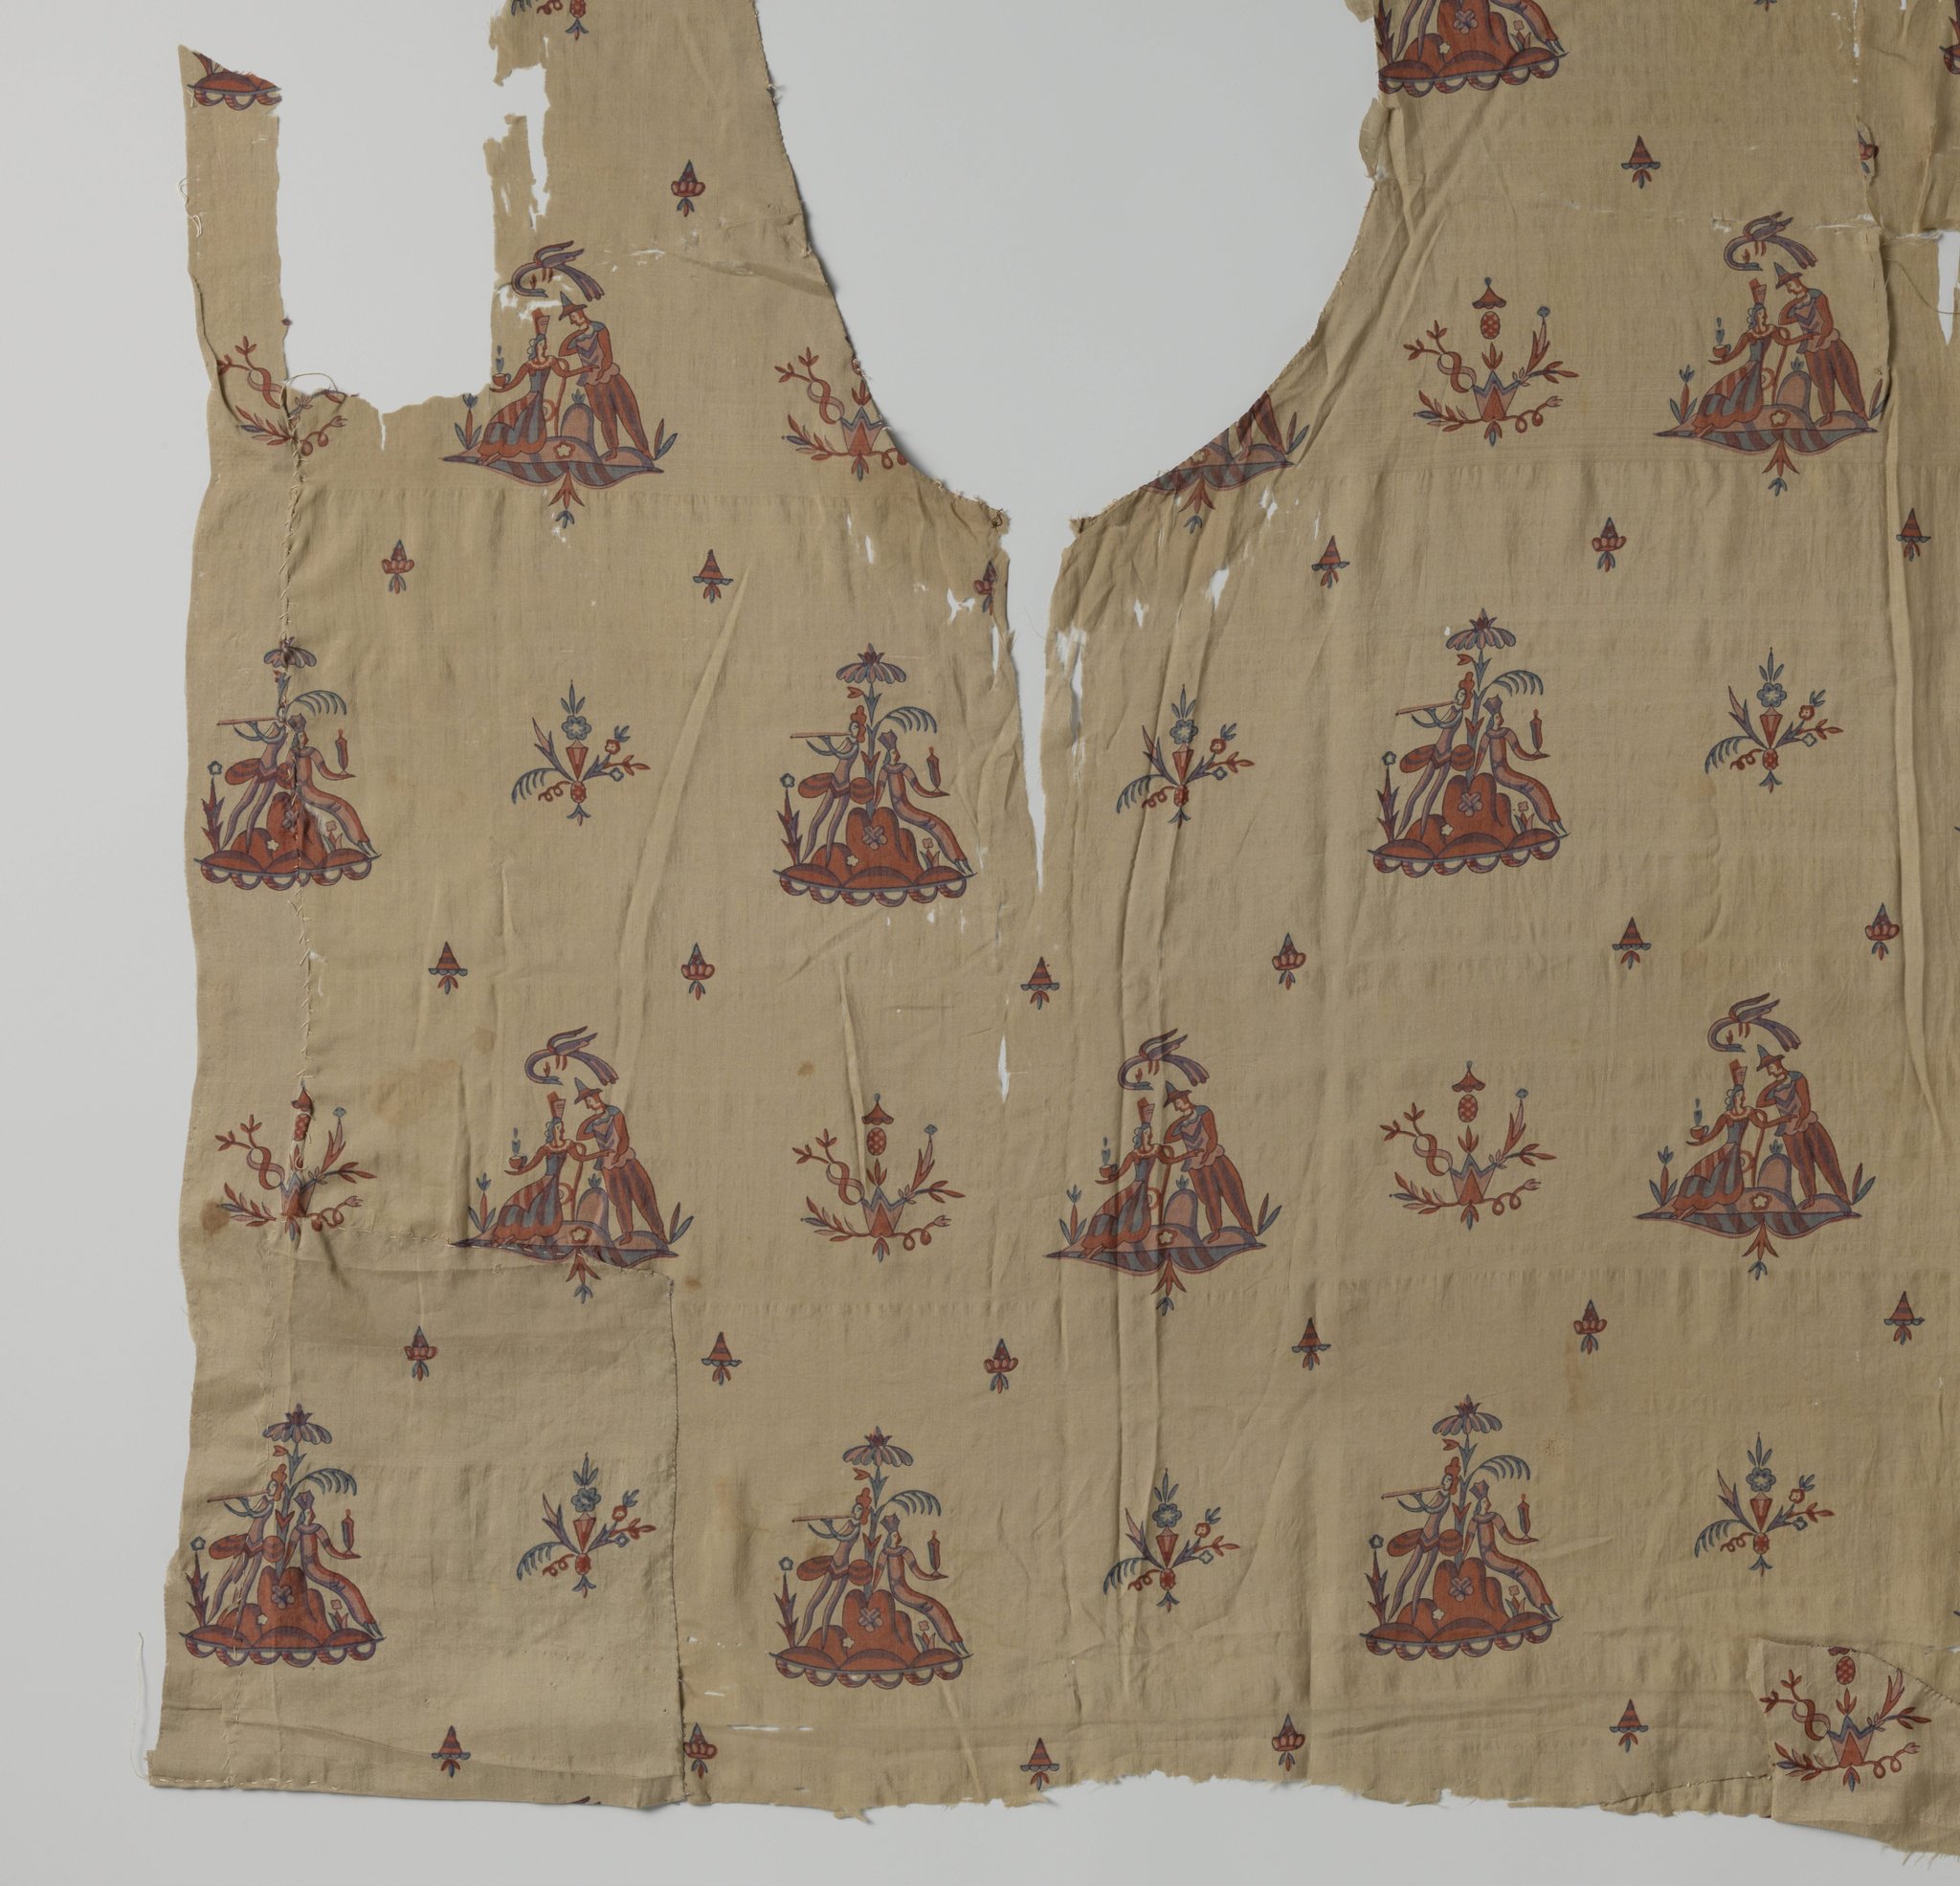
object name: fragment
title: Fragment zijdeweefsel met opgedrukt patroon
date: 1920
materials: silk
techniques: printing block, weave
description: Fragment zijdeweefsel. Een beige of leverkleurige grond heeft een patroon van verspringende rijen met verschillende patronen. De ene rij heeft bloemtakken tussen een grond met een boom waaronder twee mensen, de andere rij heeft bloemtakken tussen een grond waarop twee staande figuren (man en vrouw?), in de kleuren blauw, roze en rood.